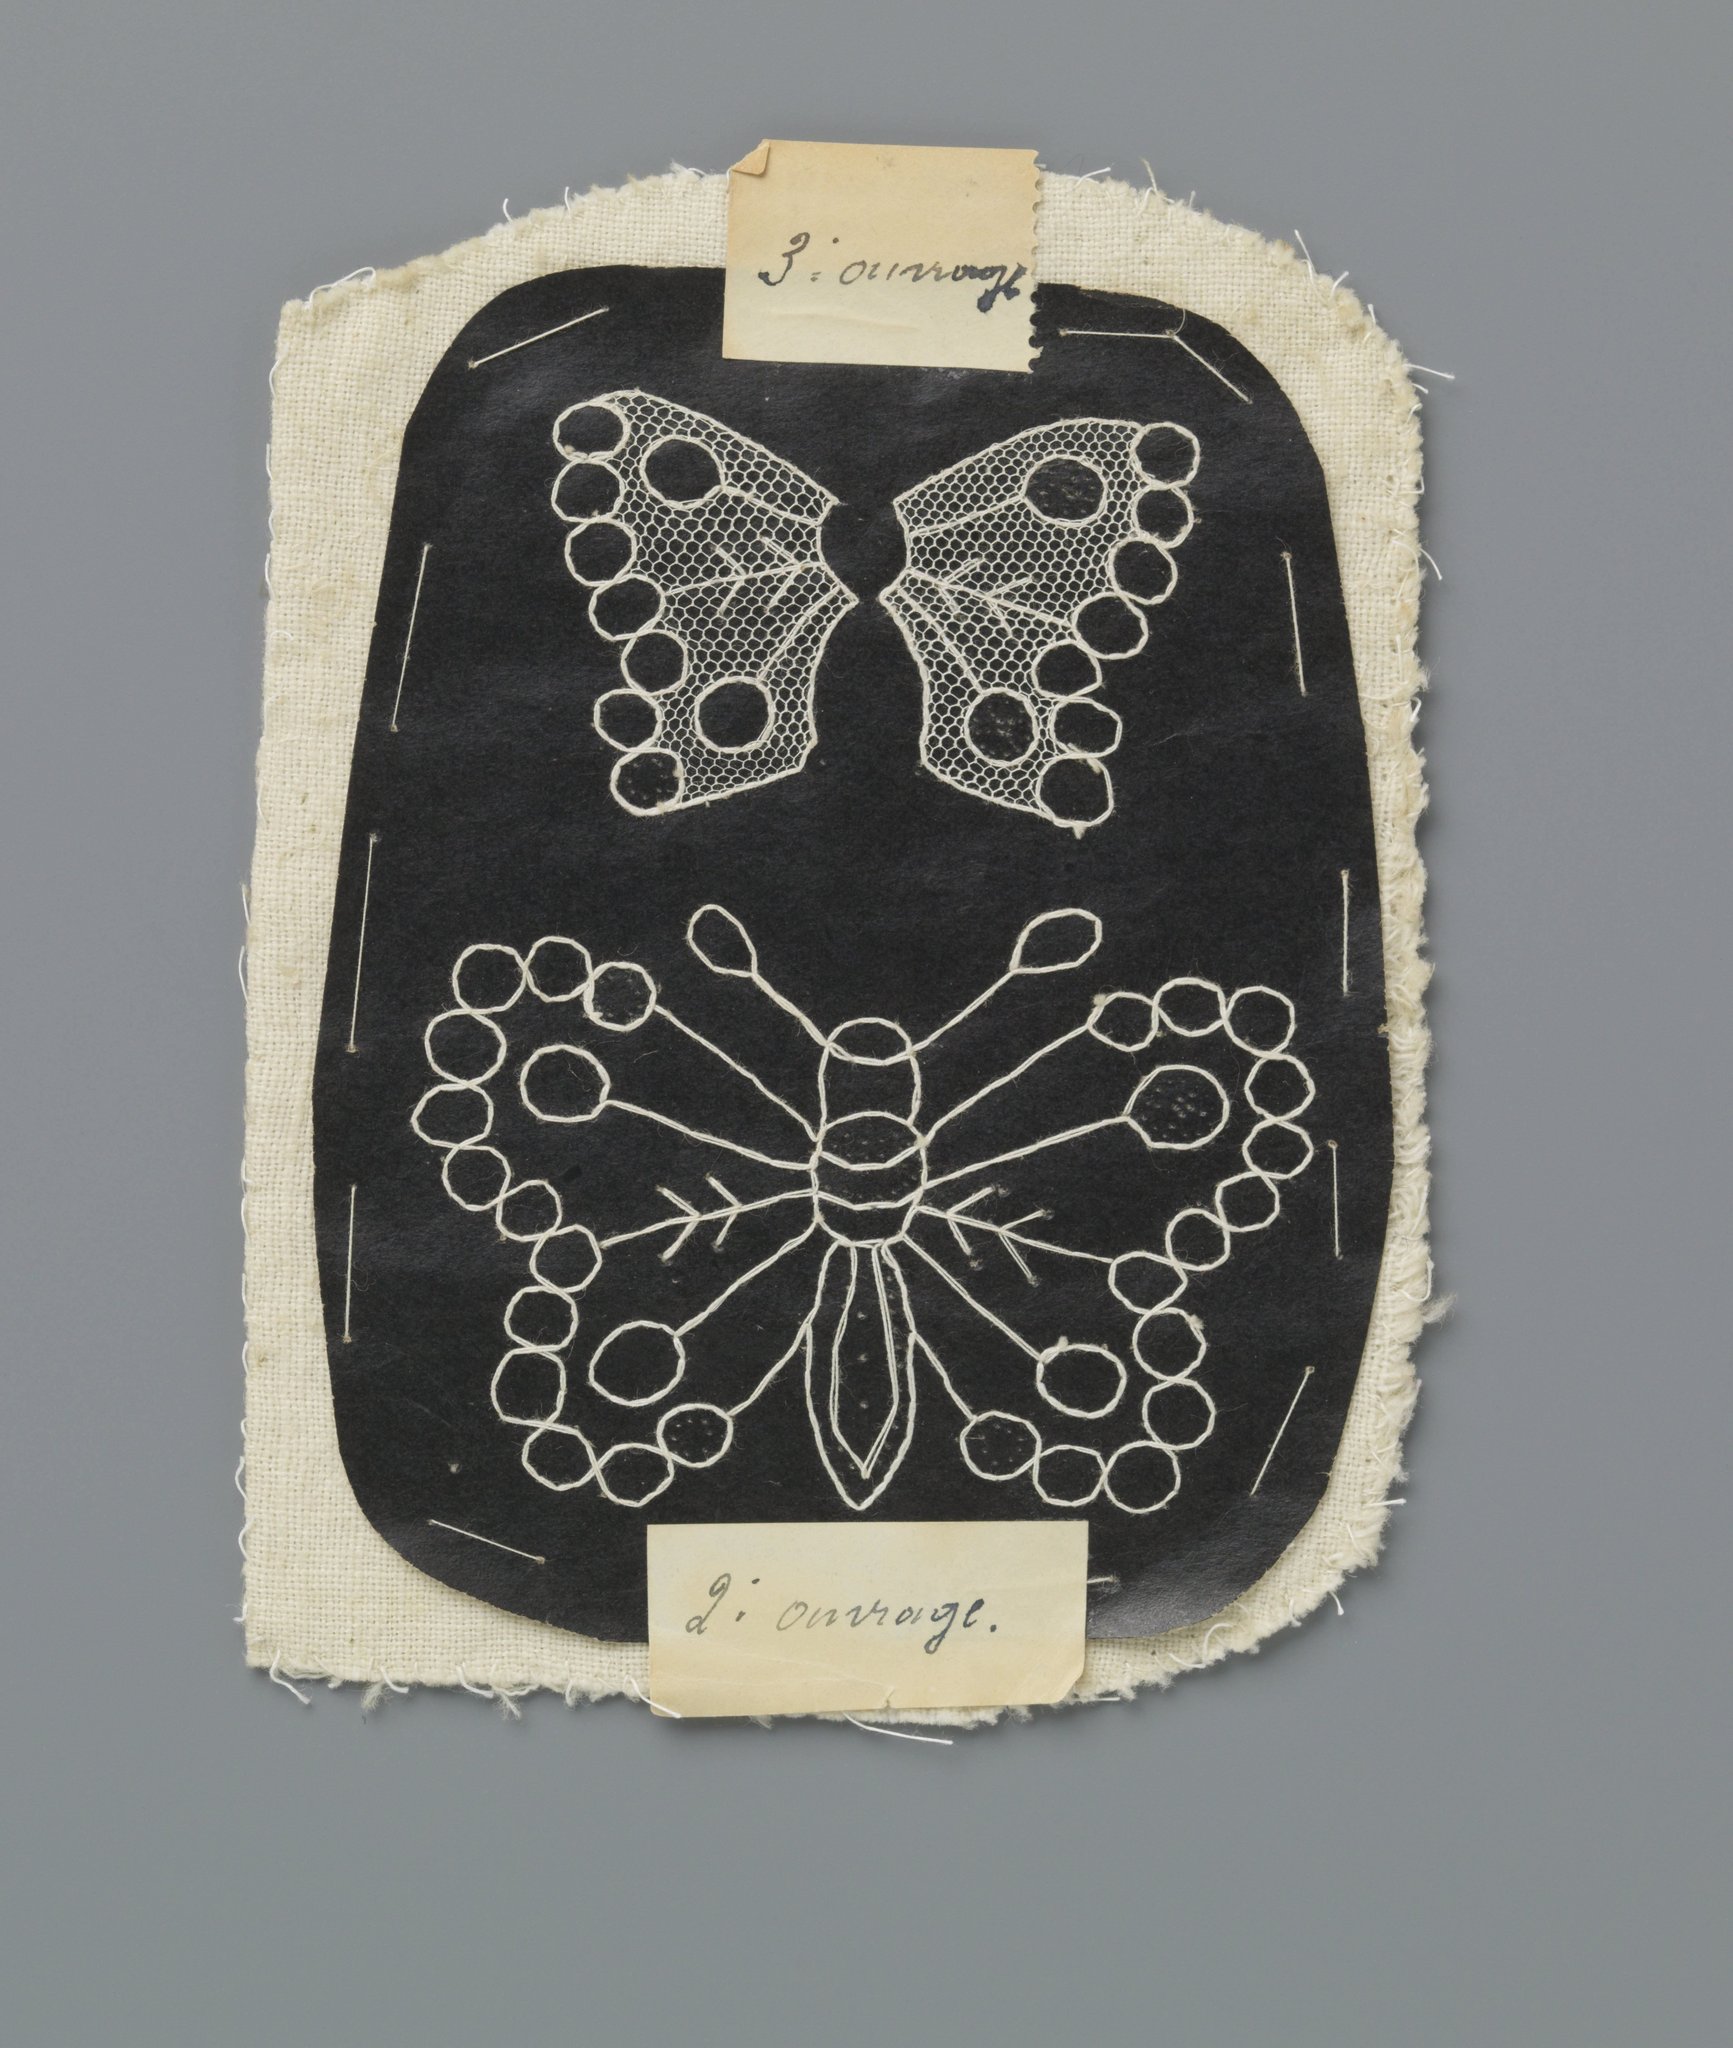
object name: prikking naaldkant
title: Gereedschap voor een naaldkantapplicatie in de vorm van een katoenen lap waarop een zwart blaadje is genaaid met witte traceerdraden in de vorm van een vlinder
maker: Anonymous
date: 1900-1914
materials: cotton, paper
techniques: sewing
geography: belgium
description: Gereedschap in de vorm van een zwart blaadje waarin het patroon van vlindervleugels en een vlinder zijn 'geprikt'. Het blaadje is op een katoenen lapje genaaid en de patroonlijnen van de vlinder (onderaan) zijn met witte traceerdraden door het blaadje en het lapje genaaid. Hierbij is een wit strookje papier geplakt met de tekst "2e ouvrage" (tweede werk). De extra vlindervleugels (bovenaan) zijn ook op die manier bewerkt en bovendien opgevuld met een gaaskantgrond. Hierbij is een wit strookje papier geplakt met de tekst "3e ouvrage" (derde werk). Het behoort tot een serie van in totaal 4 objecten waarin de ontwikkeling wordt gedemonstreerd om te komen tot een vlinder van Brusselse naaldkant.